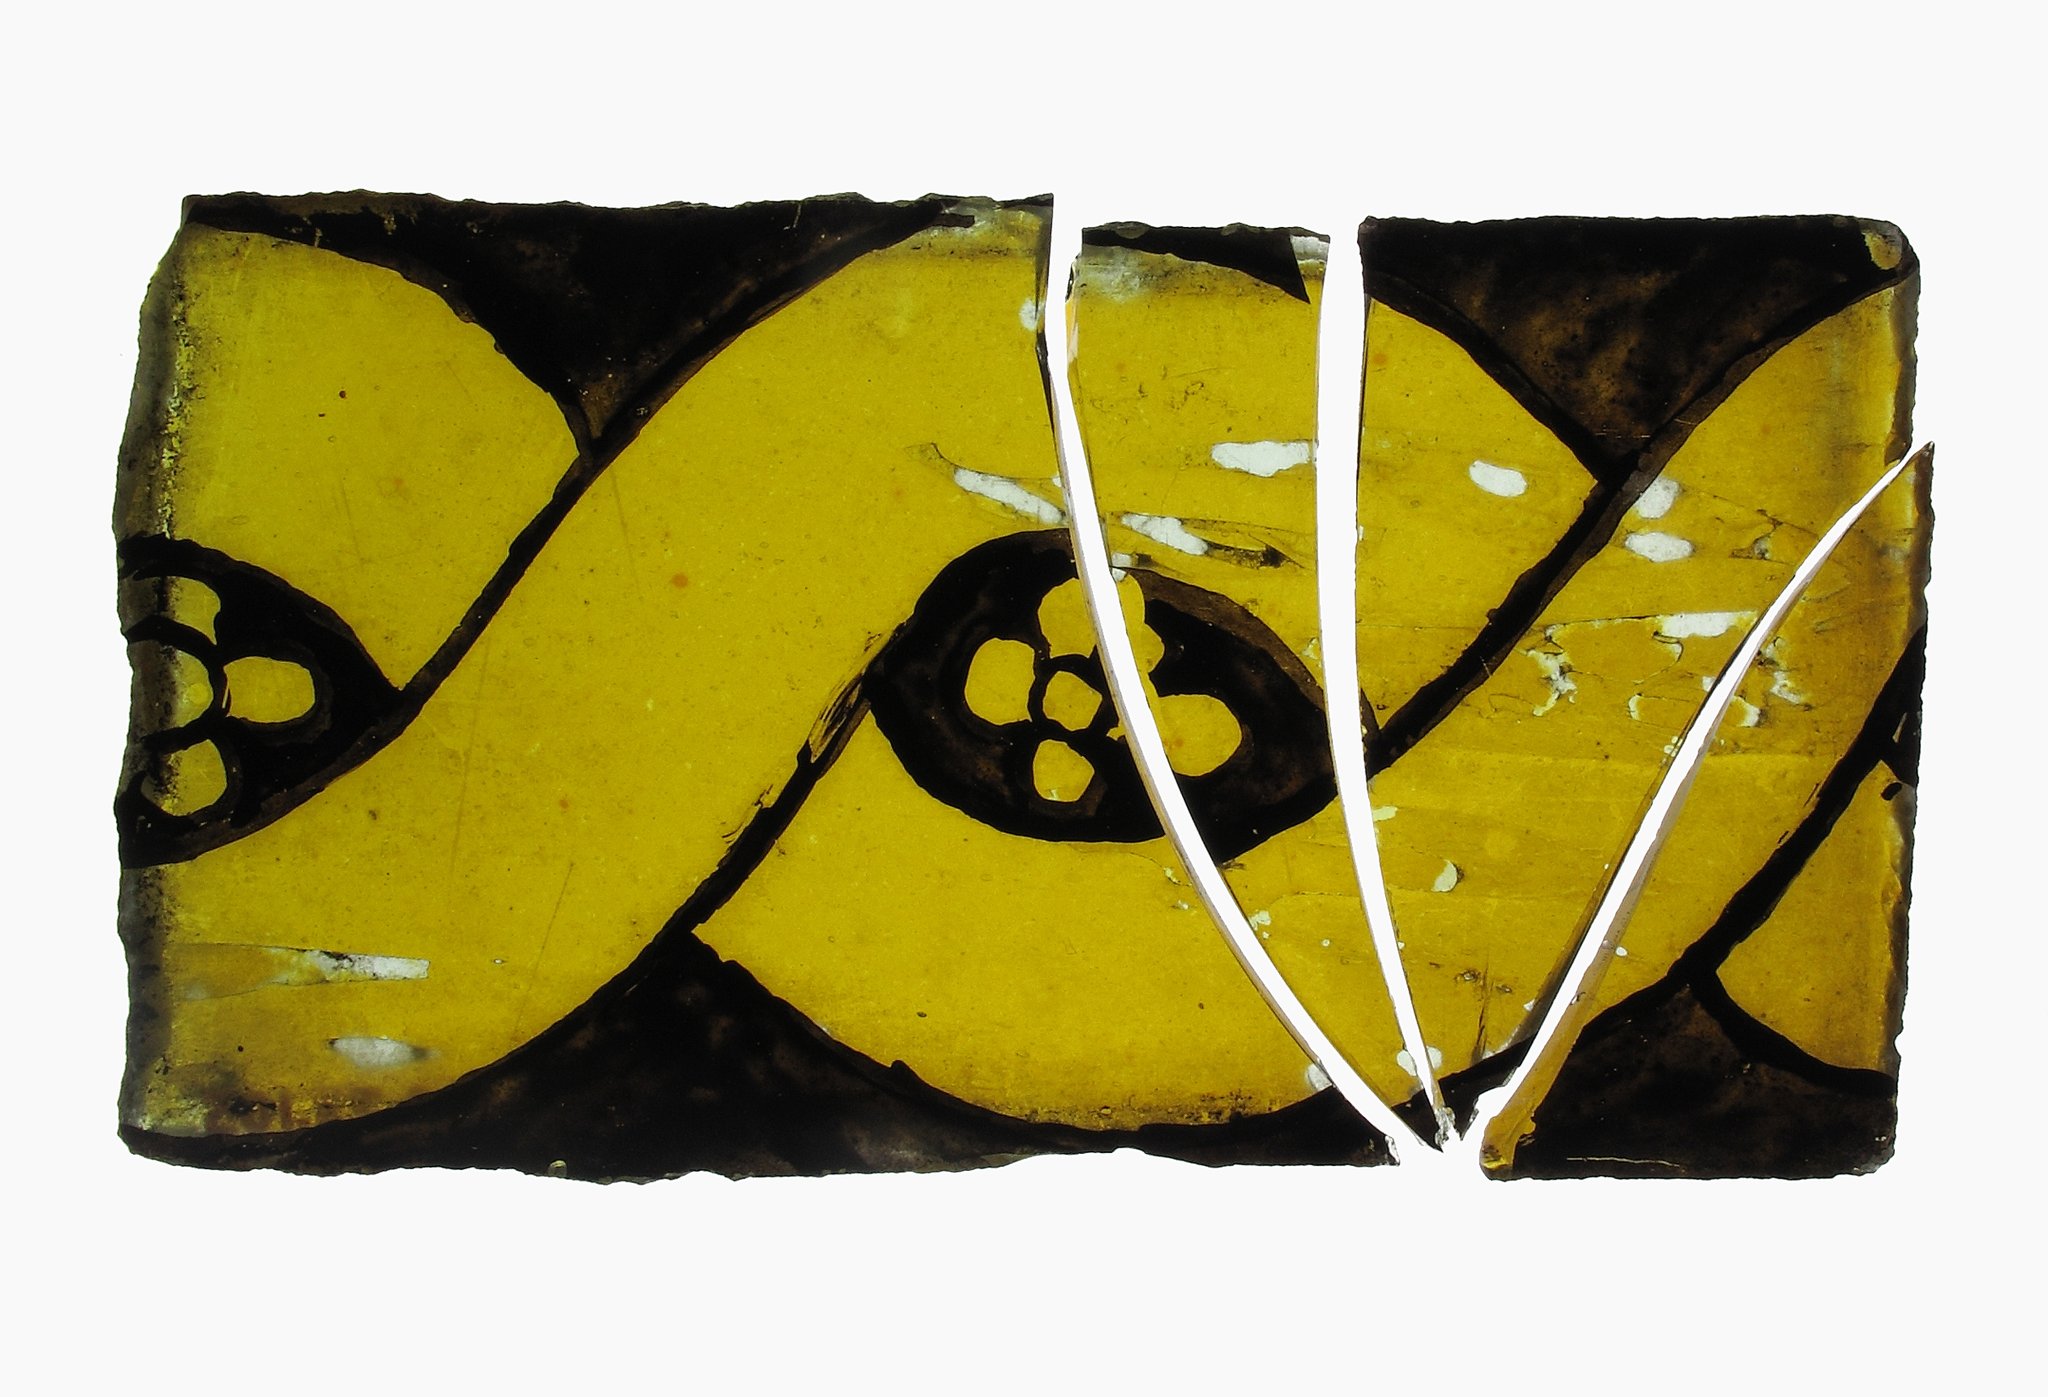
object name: fragment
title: Glass Fragment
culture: european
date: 1401-1500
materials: glass, metal